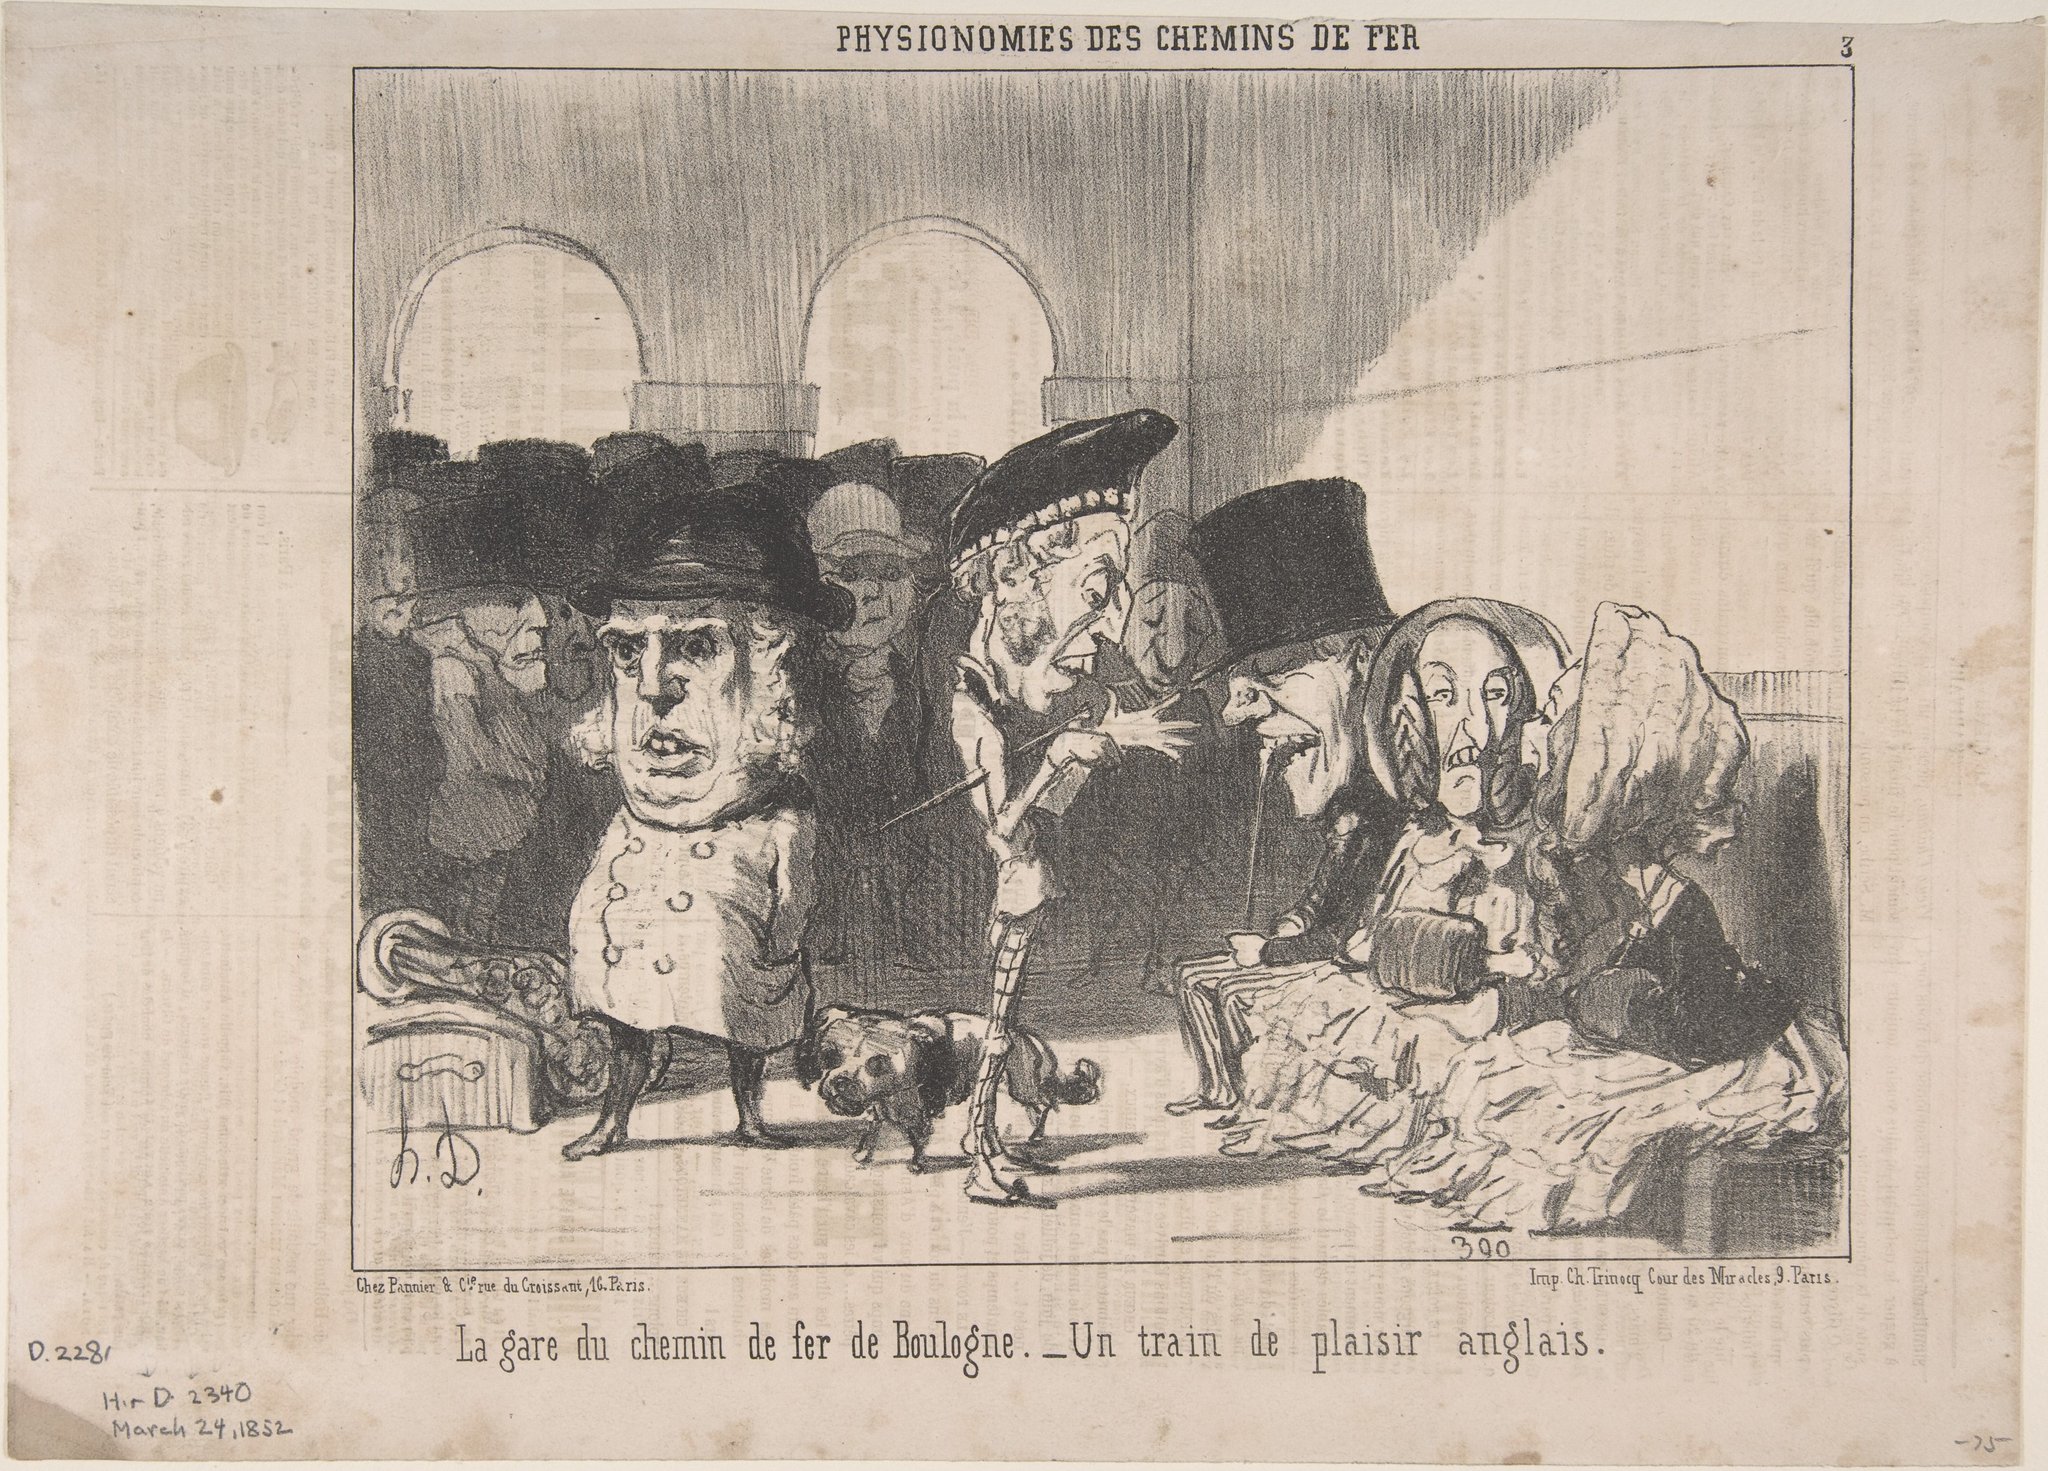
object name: print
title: The Boulogne Train Station. An English Excursion Train (La gare de chemin de fer de Boulogne. Un train de plaisir anglais), from Physionomies des Chemins de Fer (Physiognomies of the Railways)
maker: honoré daumier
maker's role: artist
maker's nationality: french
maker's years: 1808-1879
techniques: lithograph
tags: satire,men,women,dogs